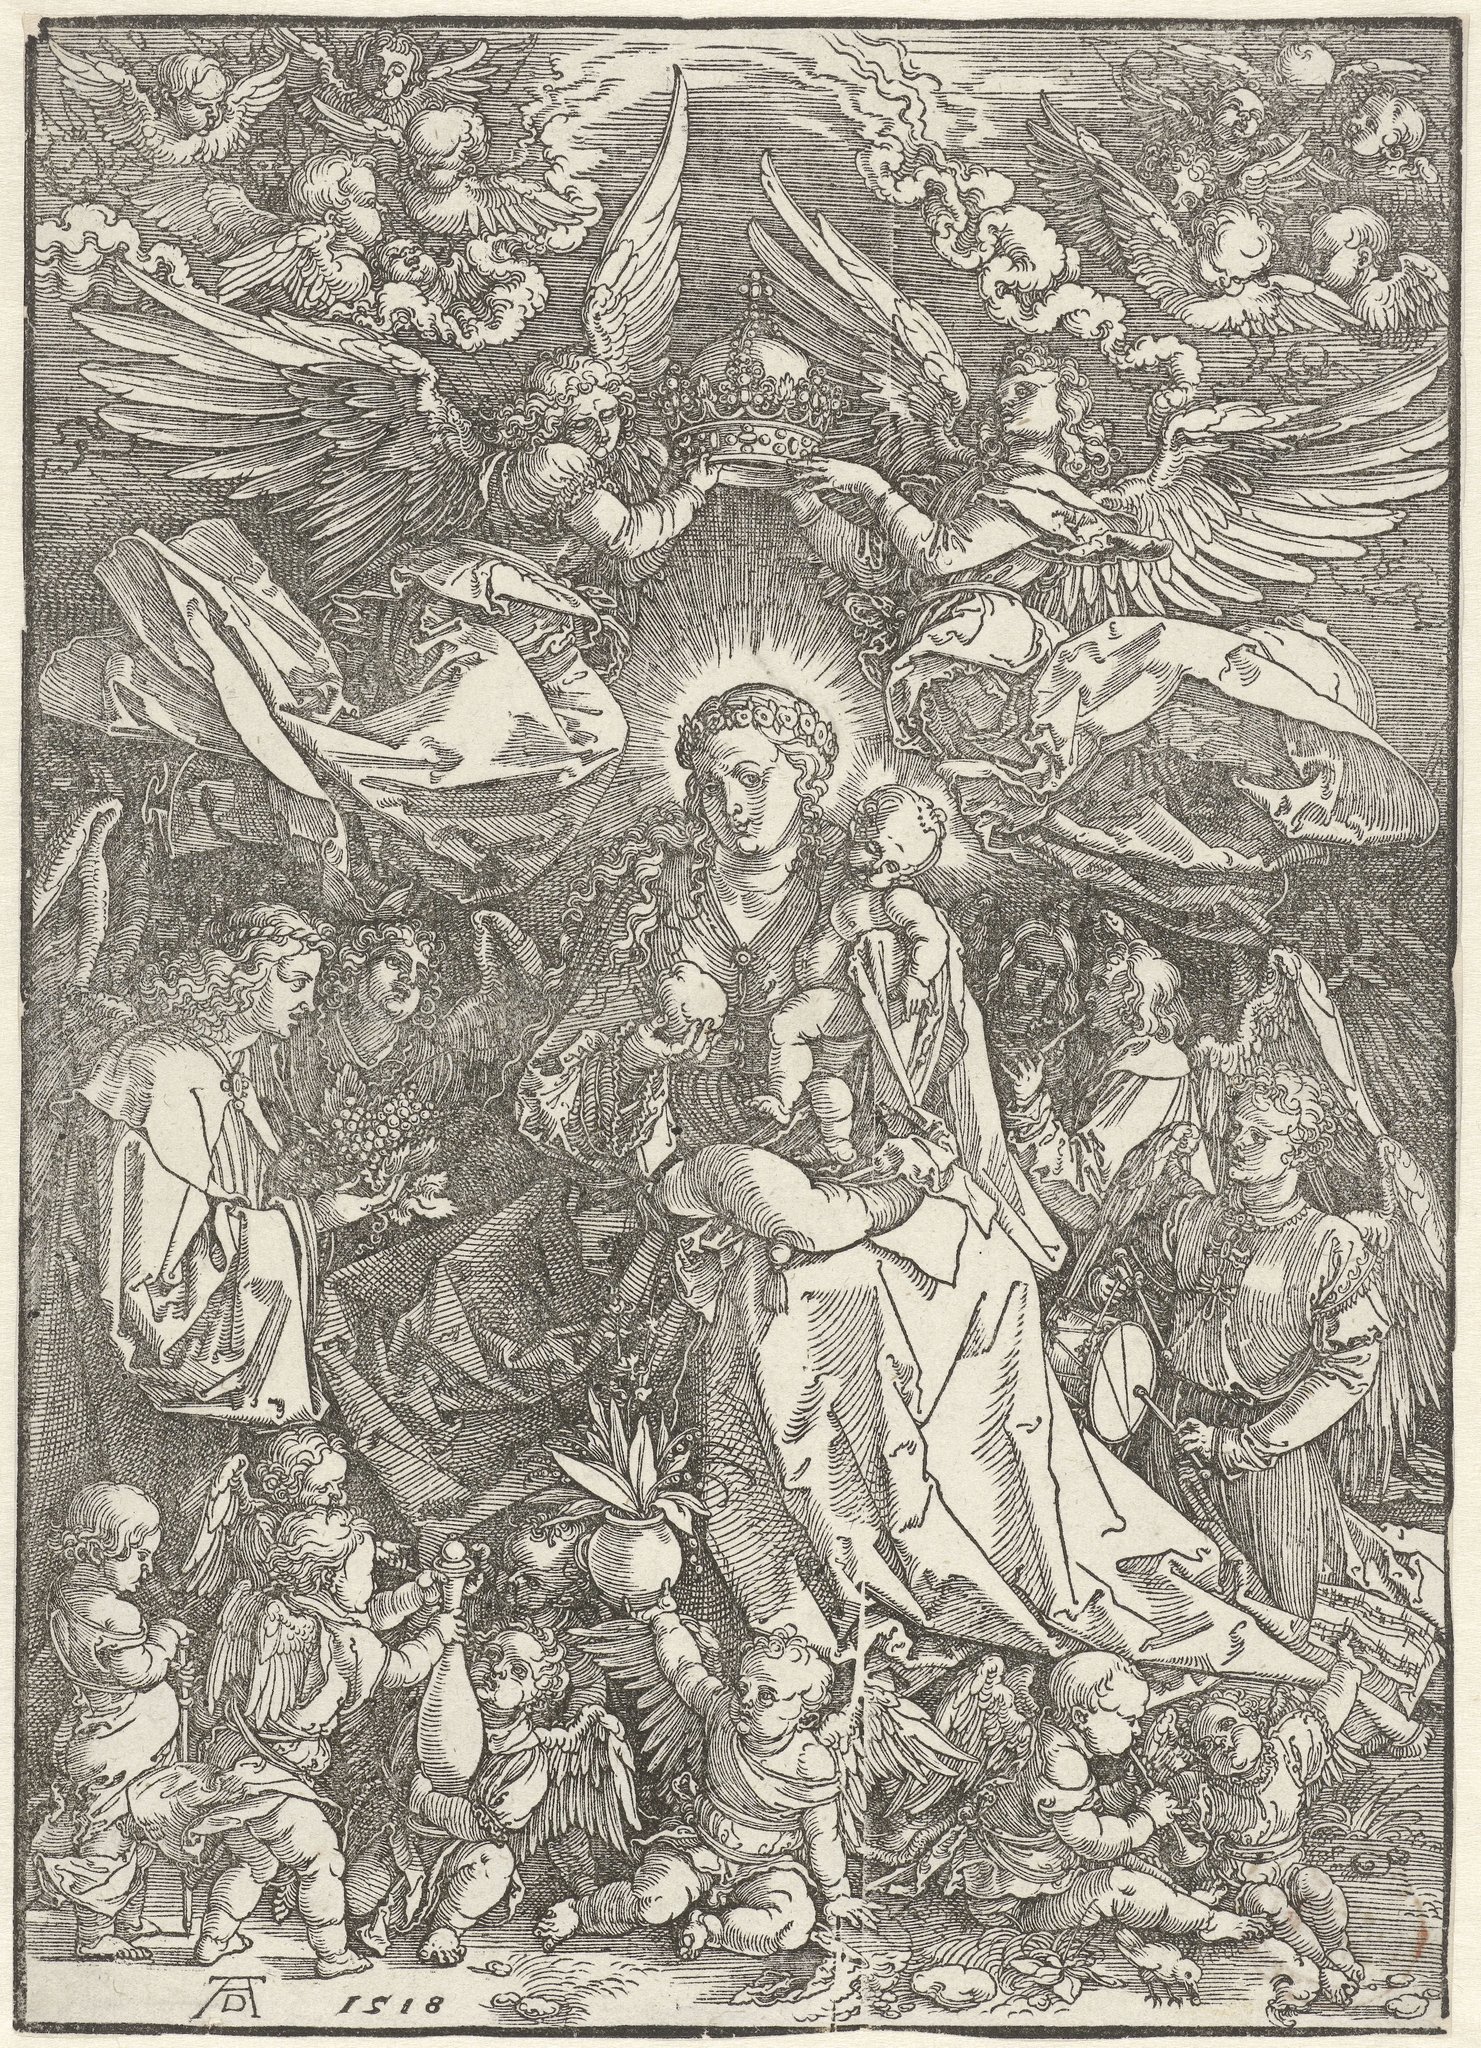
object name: print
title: Maria als koningin der engelen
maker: albrecht dürer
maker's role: draughtsman, painter, print maker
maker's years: 1471-1528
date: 1518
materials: paper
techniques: woodcut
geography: nuremberg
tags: mary sitting or enthroned, the christ-child in front of her, standing in her lap (or in front of her bosom), angels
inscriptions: collector's mark: Lugt 240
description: Maria, het Christuskind staand op de schoot, is omgeven door vele grote en kleine engelen. Twee van hen kronen haar, enkelen maken muziek en één biedt haar druiven aan.